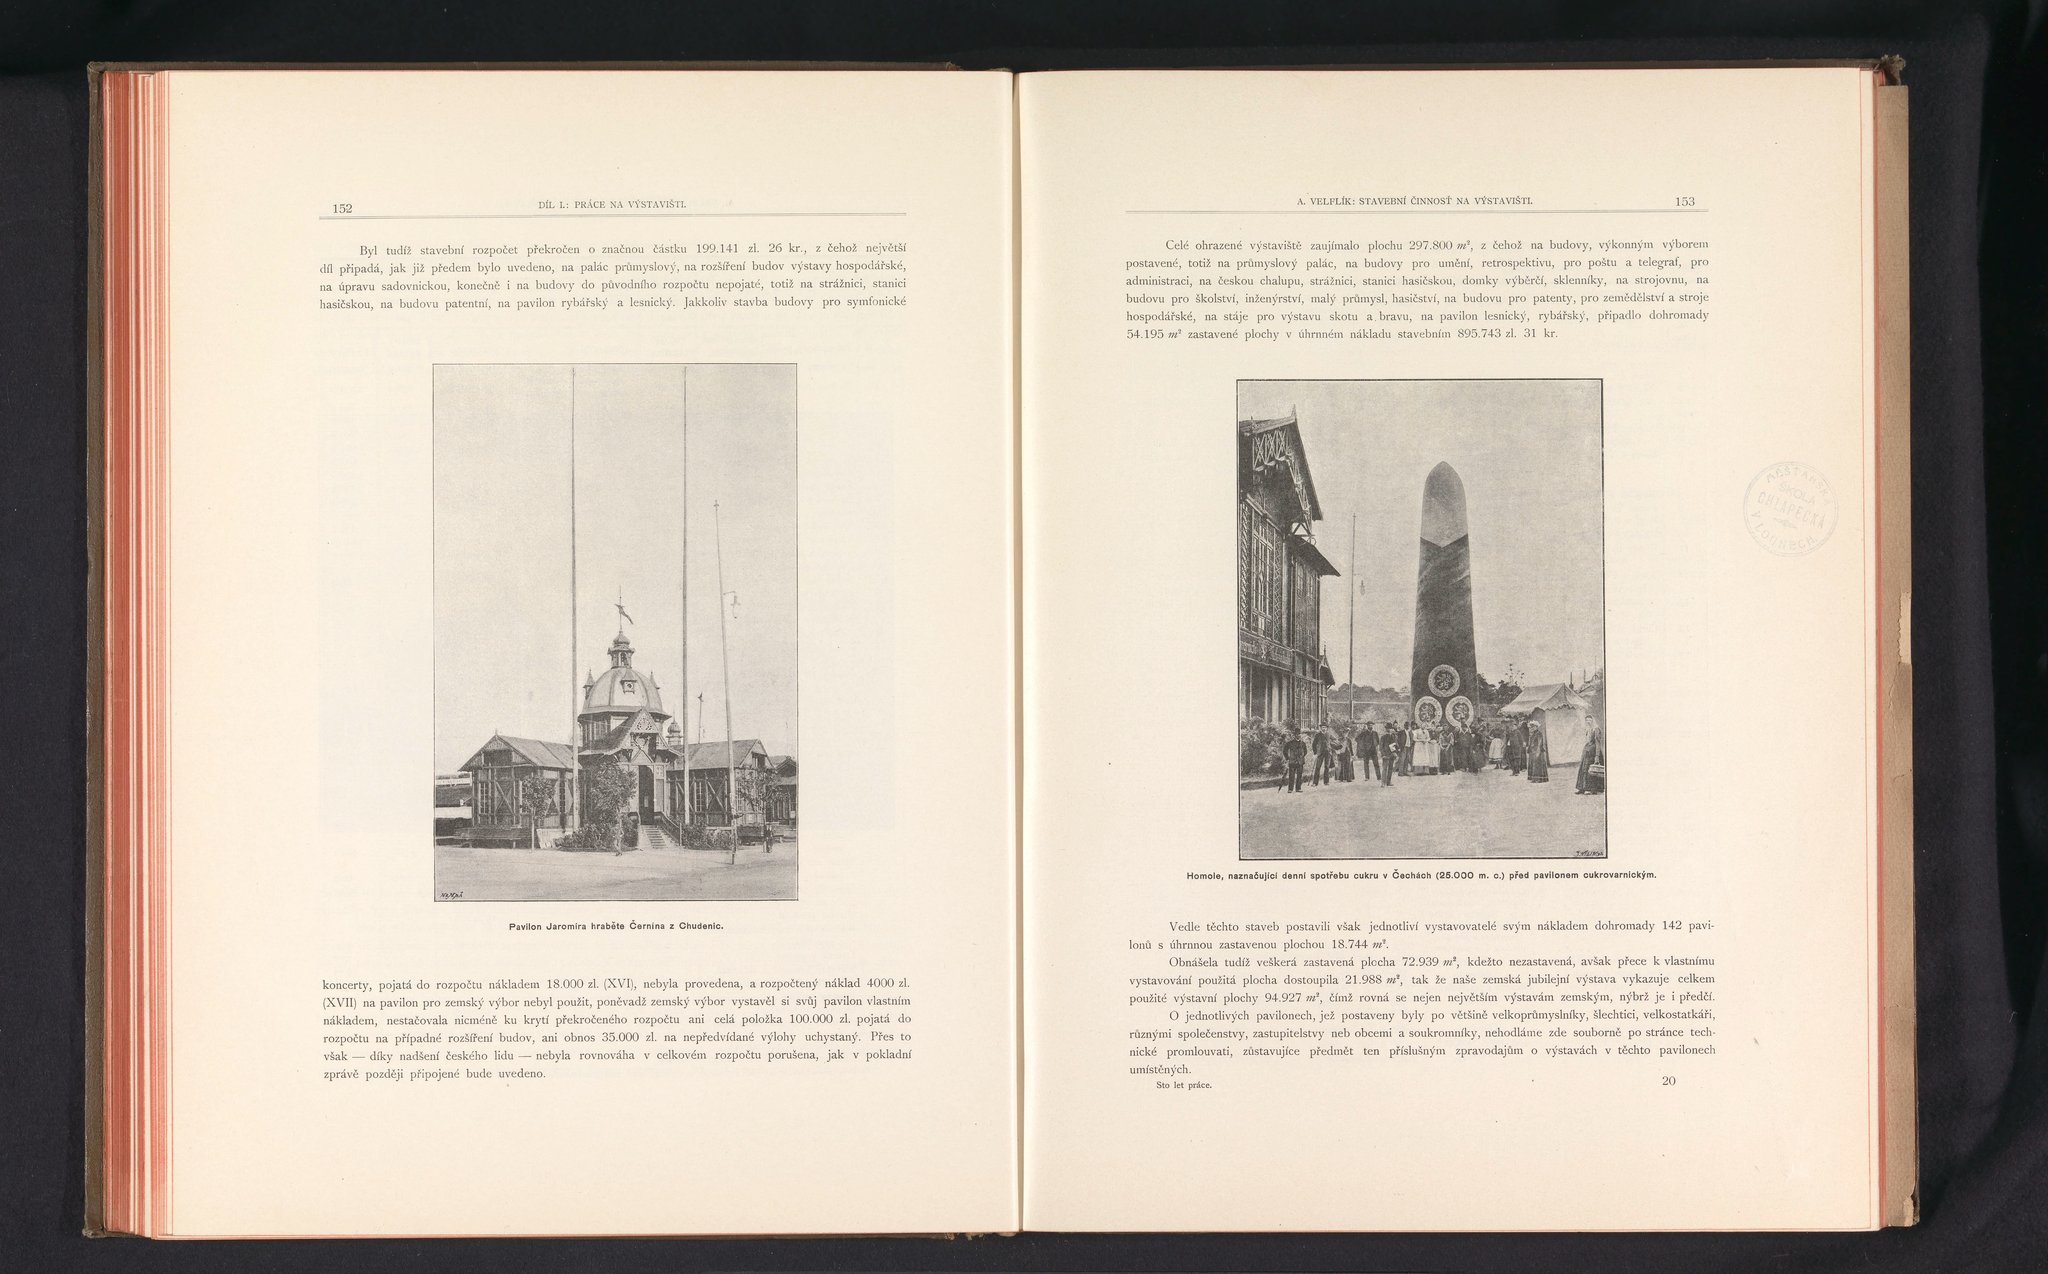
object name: page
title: Exterieur van een paviljoen op het Výstaviště te Praag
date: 1888-1893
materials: paper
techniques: autotype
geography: prague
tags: façade (of house or building), temporary exhibition, 'salon'